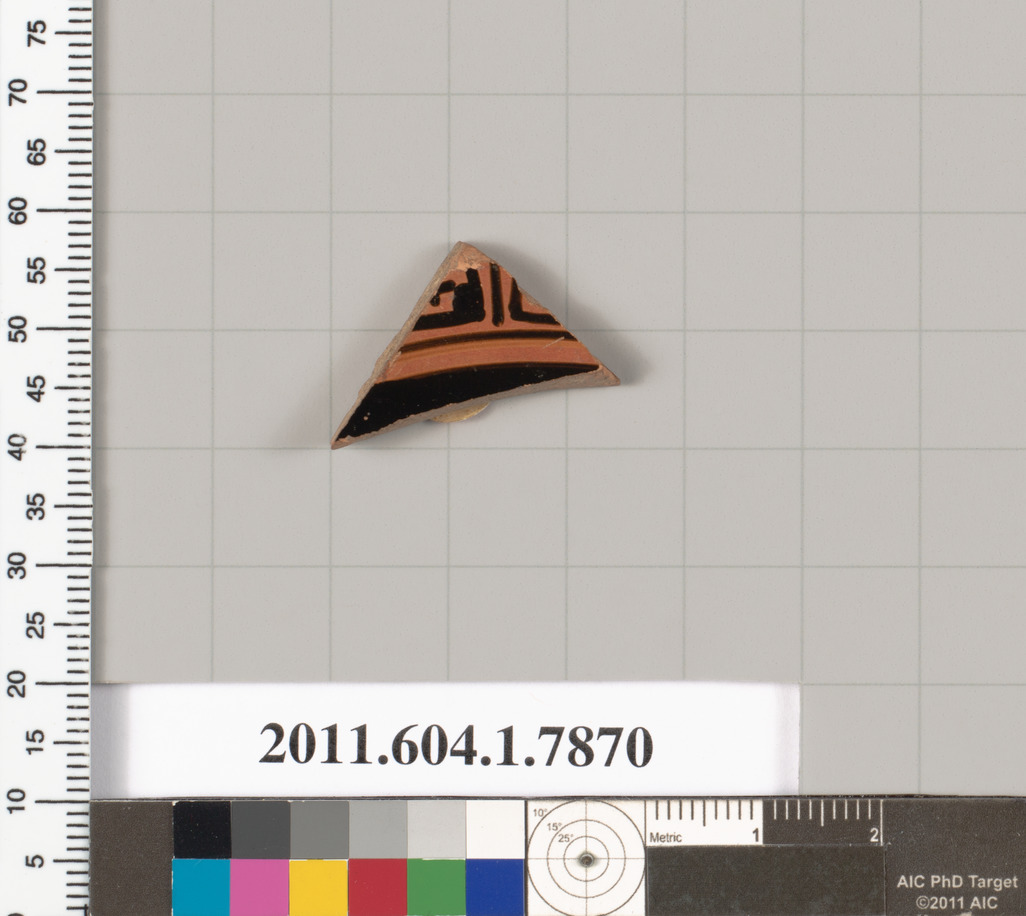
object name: kylix fragment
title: Terracotta fragment of a kylix (drinking cup)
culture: greek, attic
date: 440-420 BCE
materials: terracotta